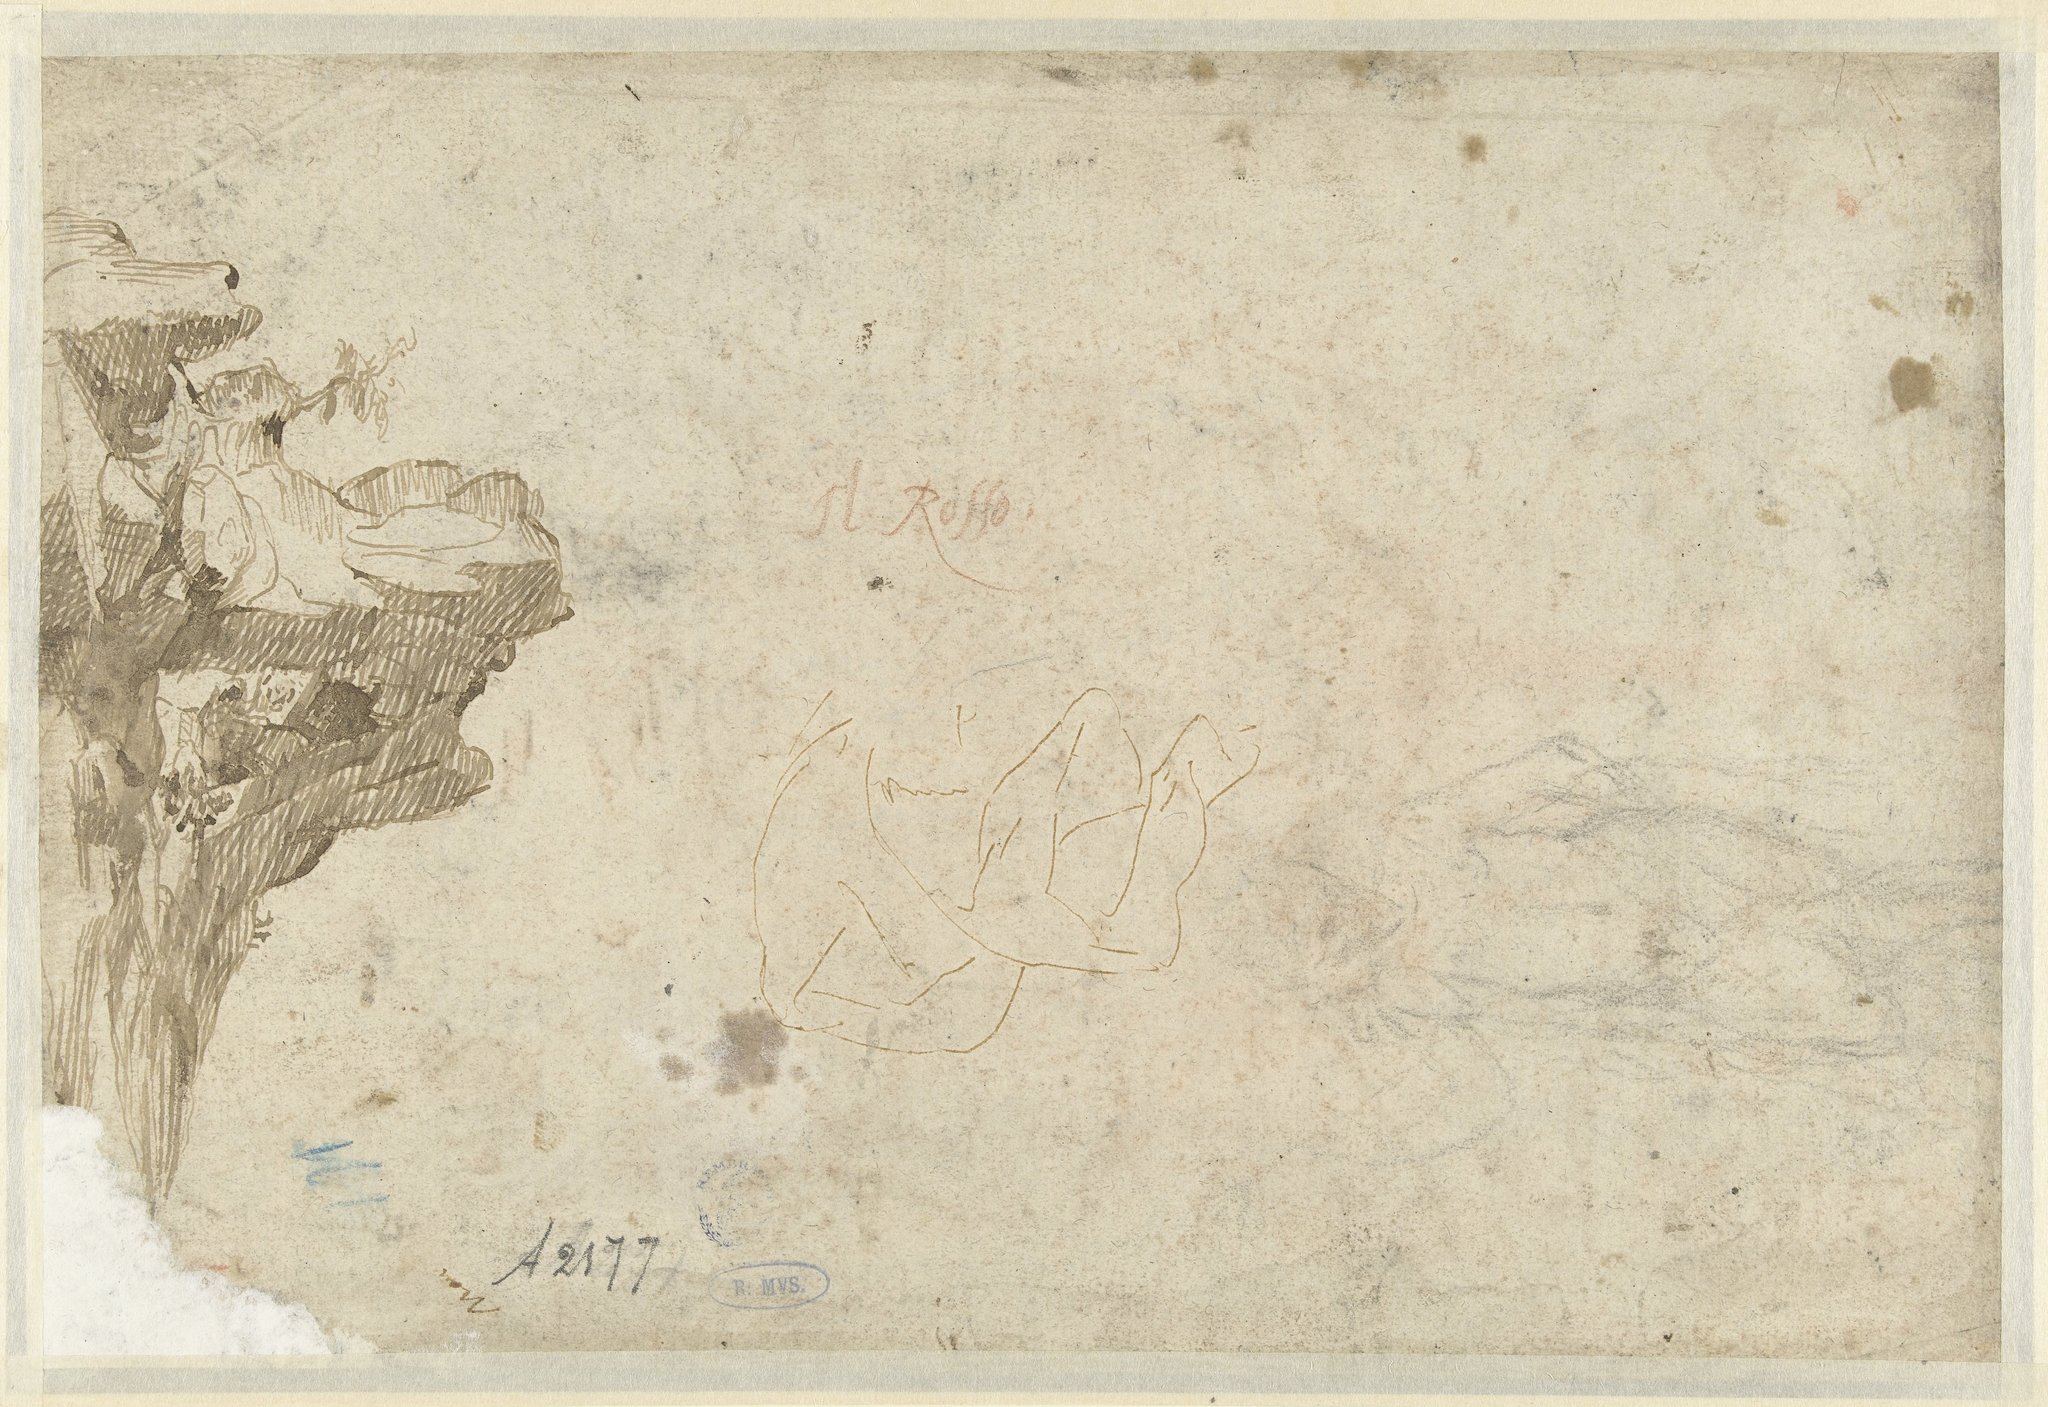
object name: drawing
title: Schetsen van een rotslandschap, een staande man en een draperiestudie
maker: Anonymous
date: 1500-1640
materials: chalk, ink, paper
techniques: brush, pen